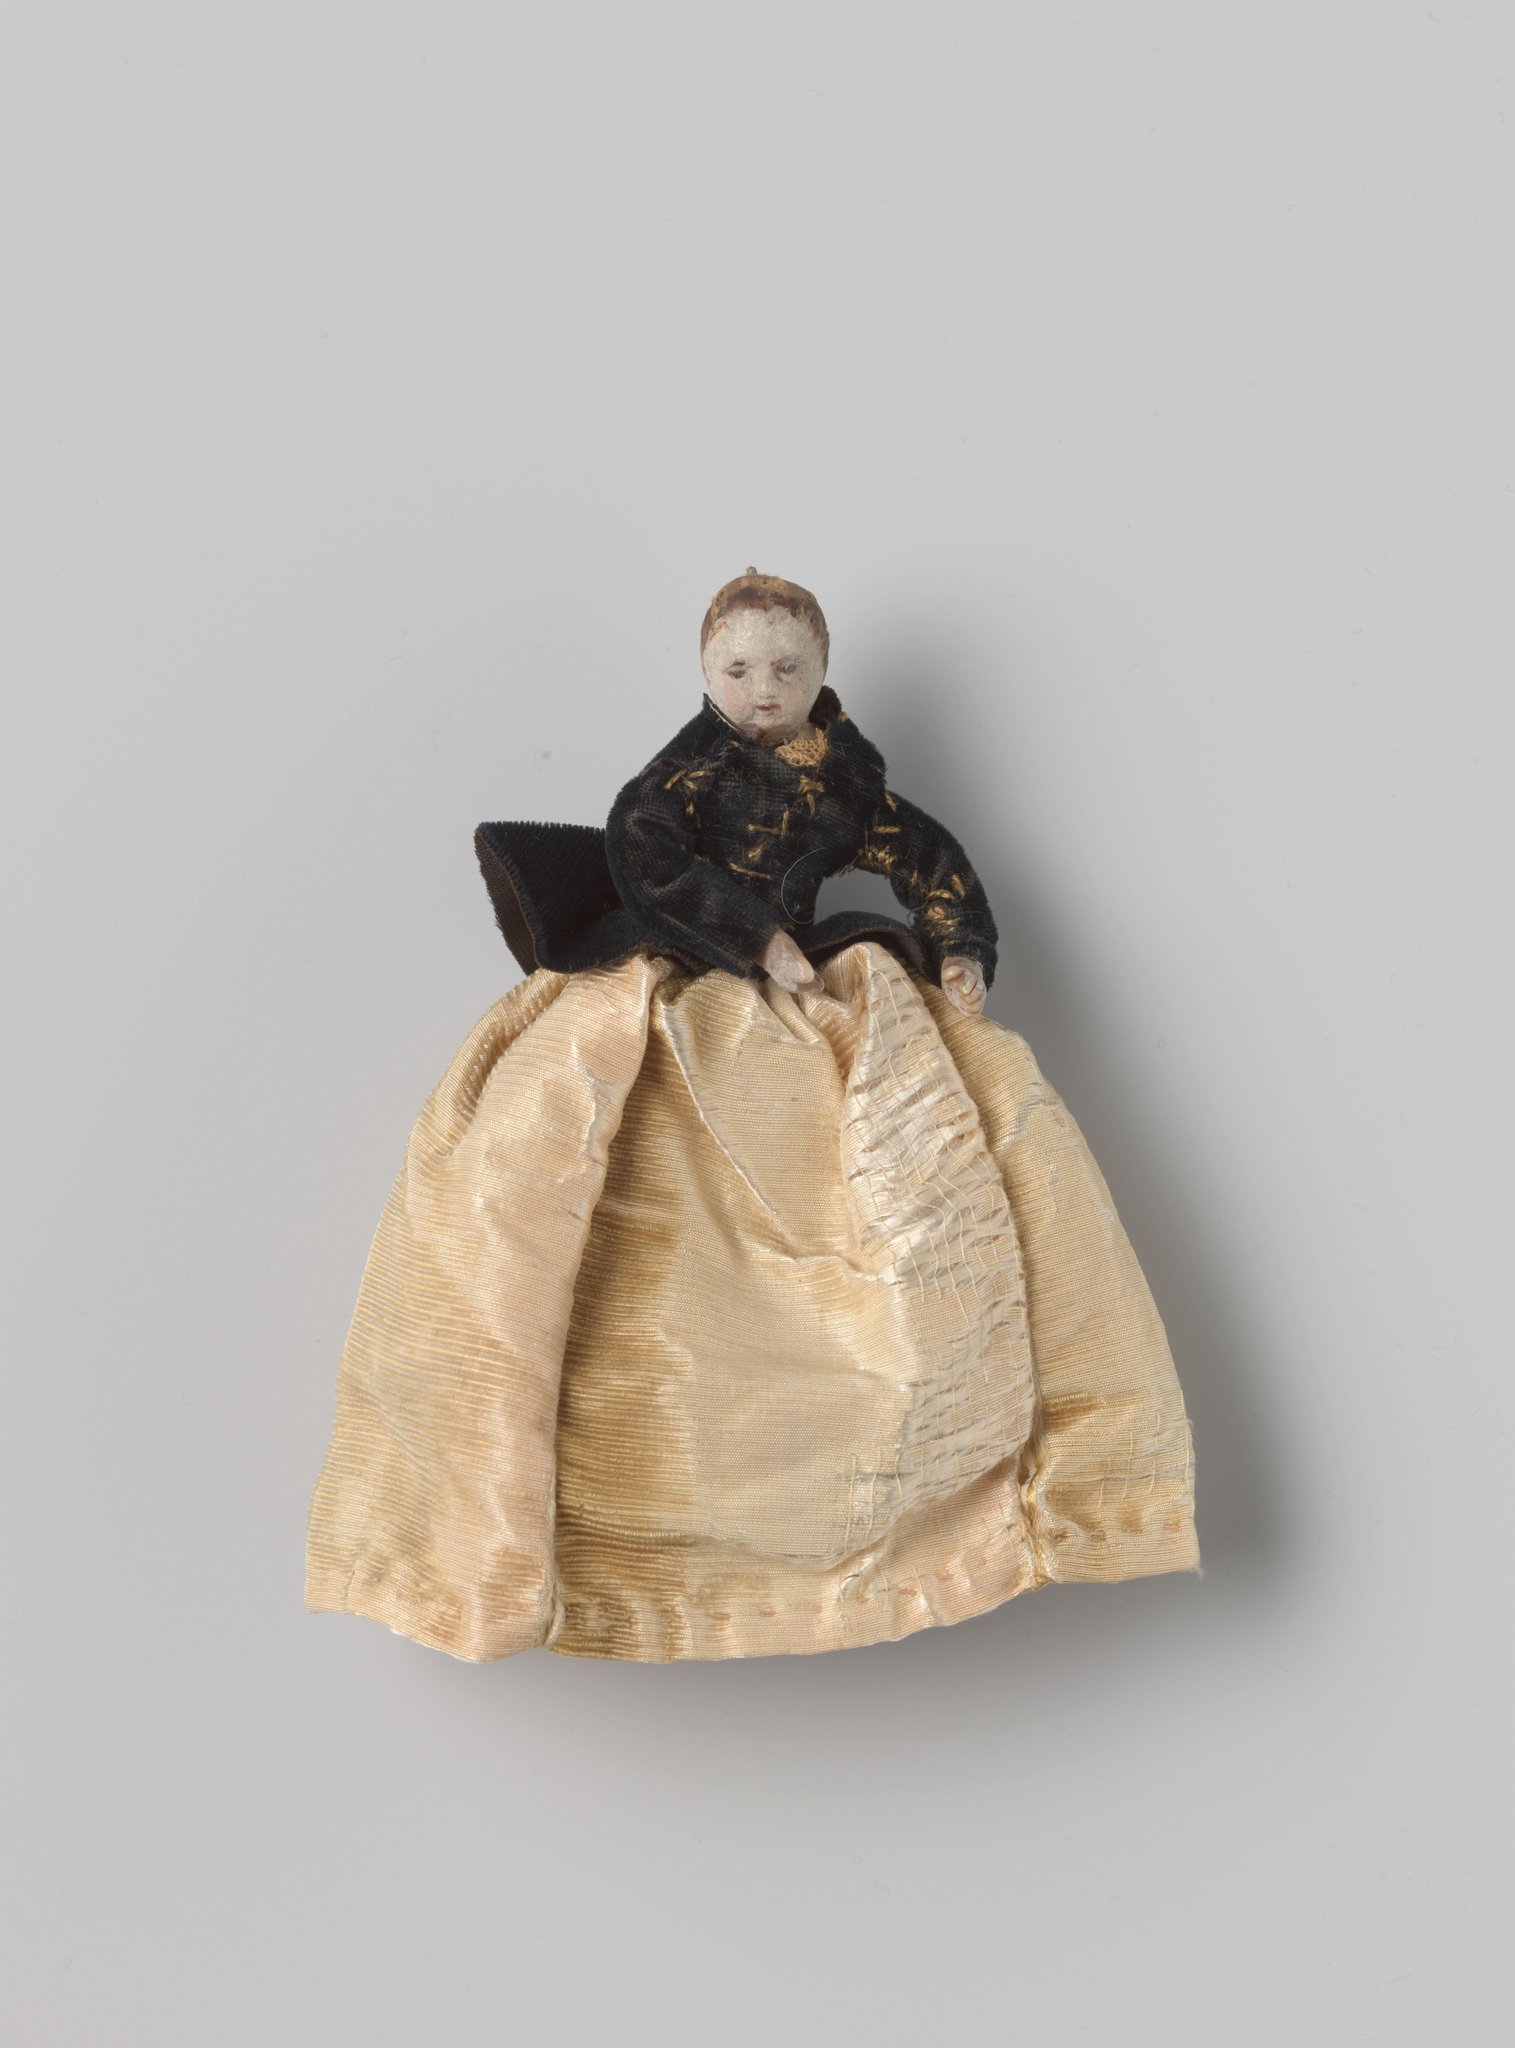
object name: doll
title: Pop, voorstellende een vrouw of kind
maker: Anonymous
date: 1700-1799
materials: cotton, silk, velvet, wax, wood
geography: amsterdam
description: Pop, voorstellende een vrouw of kind. Hoofd, handen van was, benen van hout.